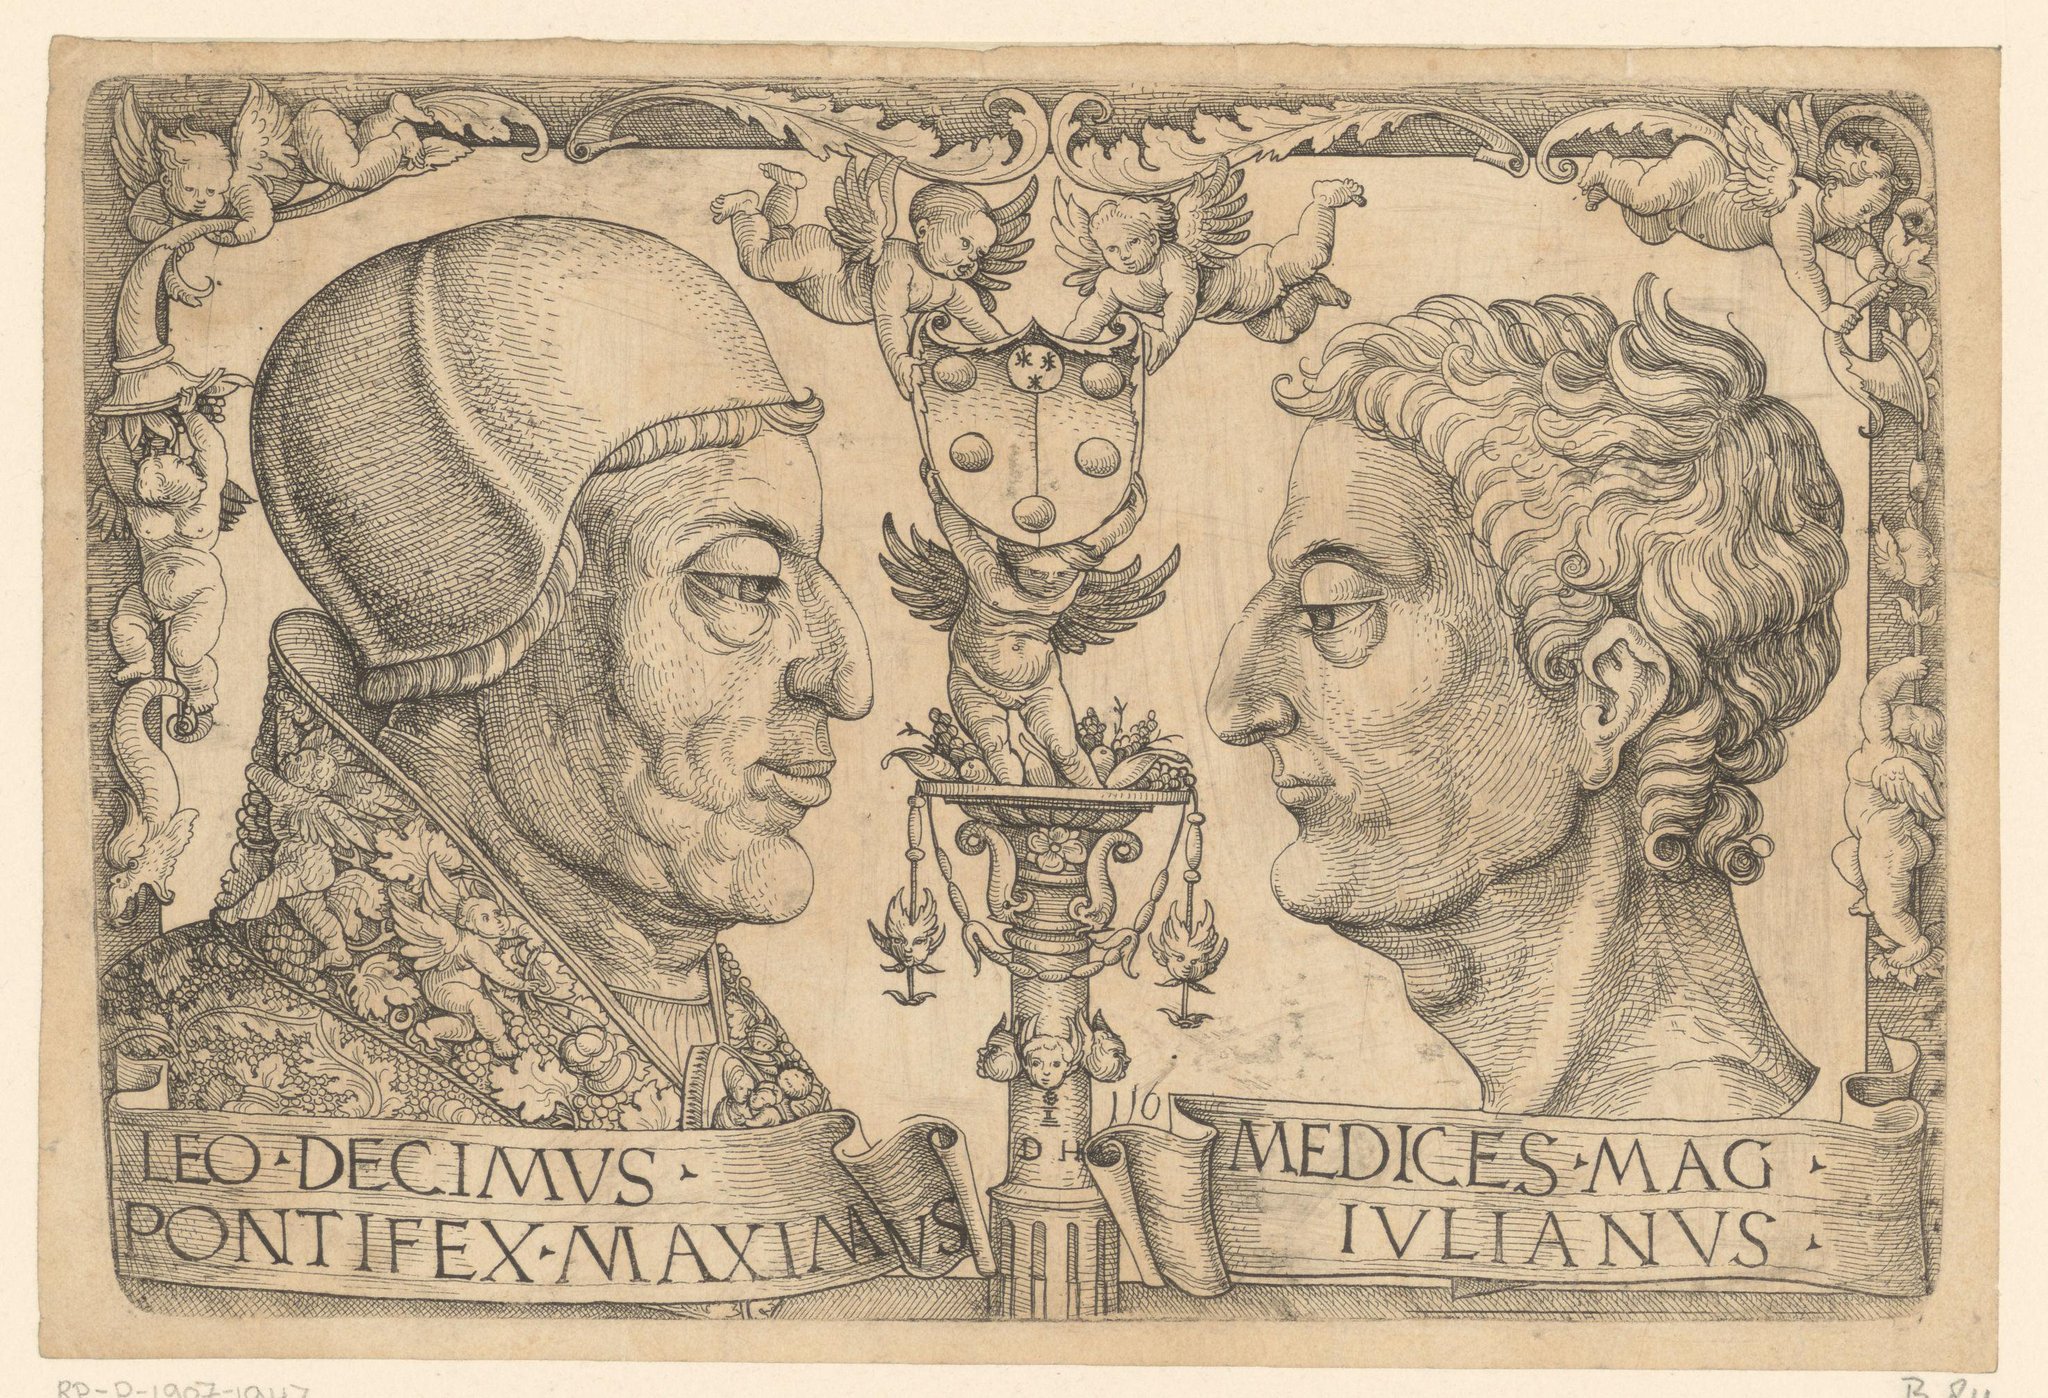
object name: print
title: Portretten van Paus Leo X en Giuliano di Piero de' Medici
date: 1513-1521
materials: paper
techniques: etching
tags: politician, rome, leo x, coat of arms (symbol of sovereignty), historical persons, pope, cupids: 'amores', 'amoretti', 'putti'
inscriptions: collector's mark: Lugt 2228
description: David Funck (1642-1709) kocht 230 ijzeren platen van de prentenmakers uit de familie Hopfer aan, nummerde deze (nu bekend als het Funck nummer) en herdrukte de verder onaangetaste platen onder de titel Operae Hopferianae in 1684 in Neurenberg. (Metzger, 2009)